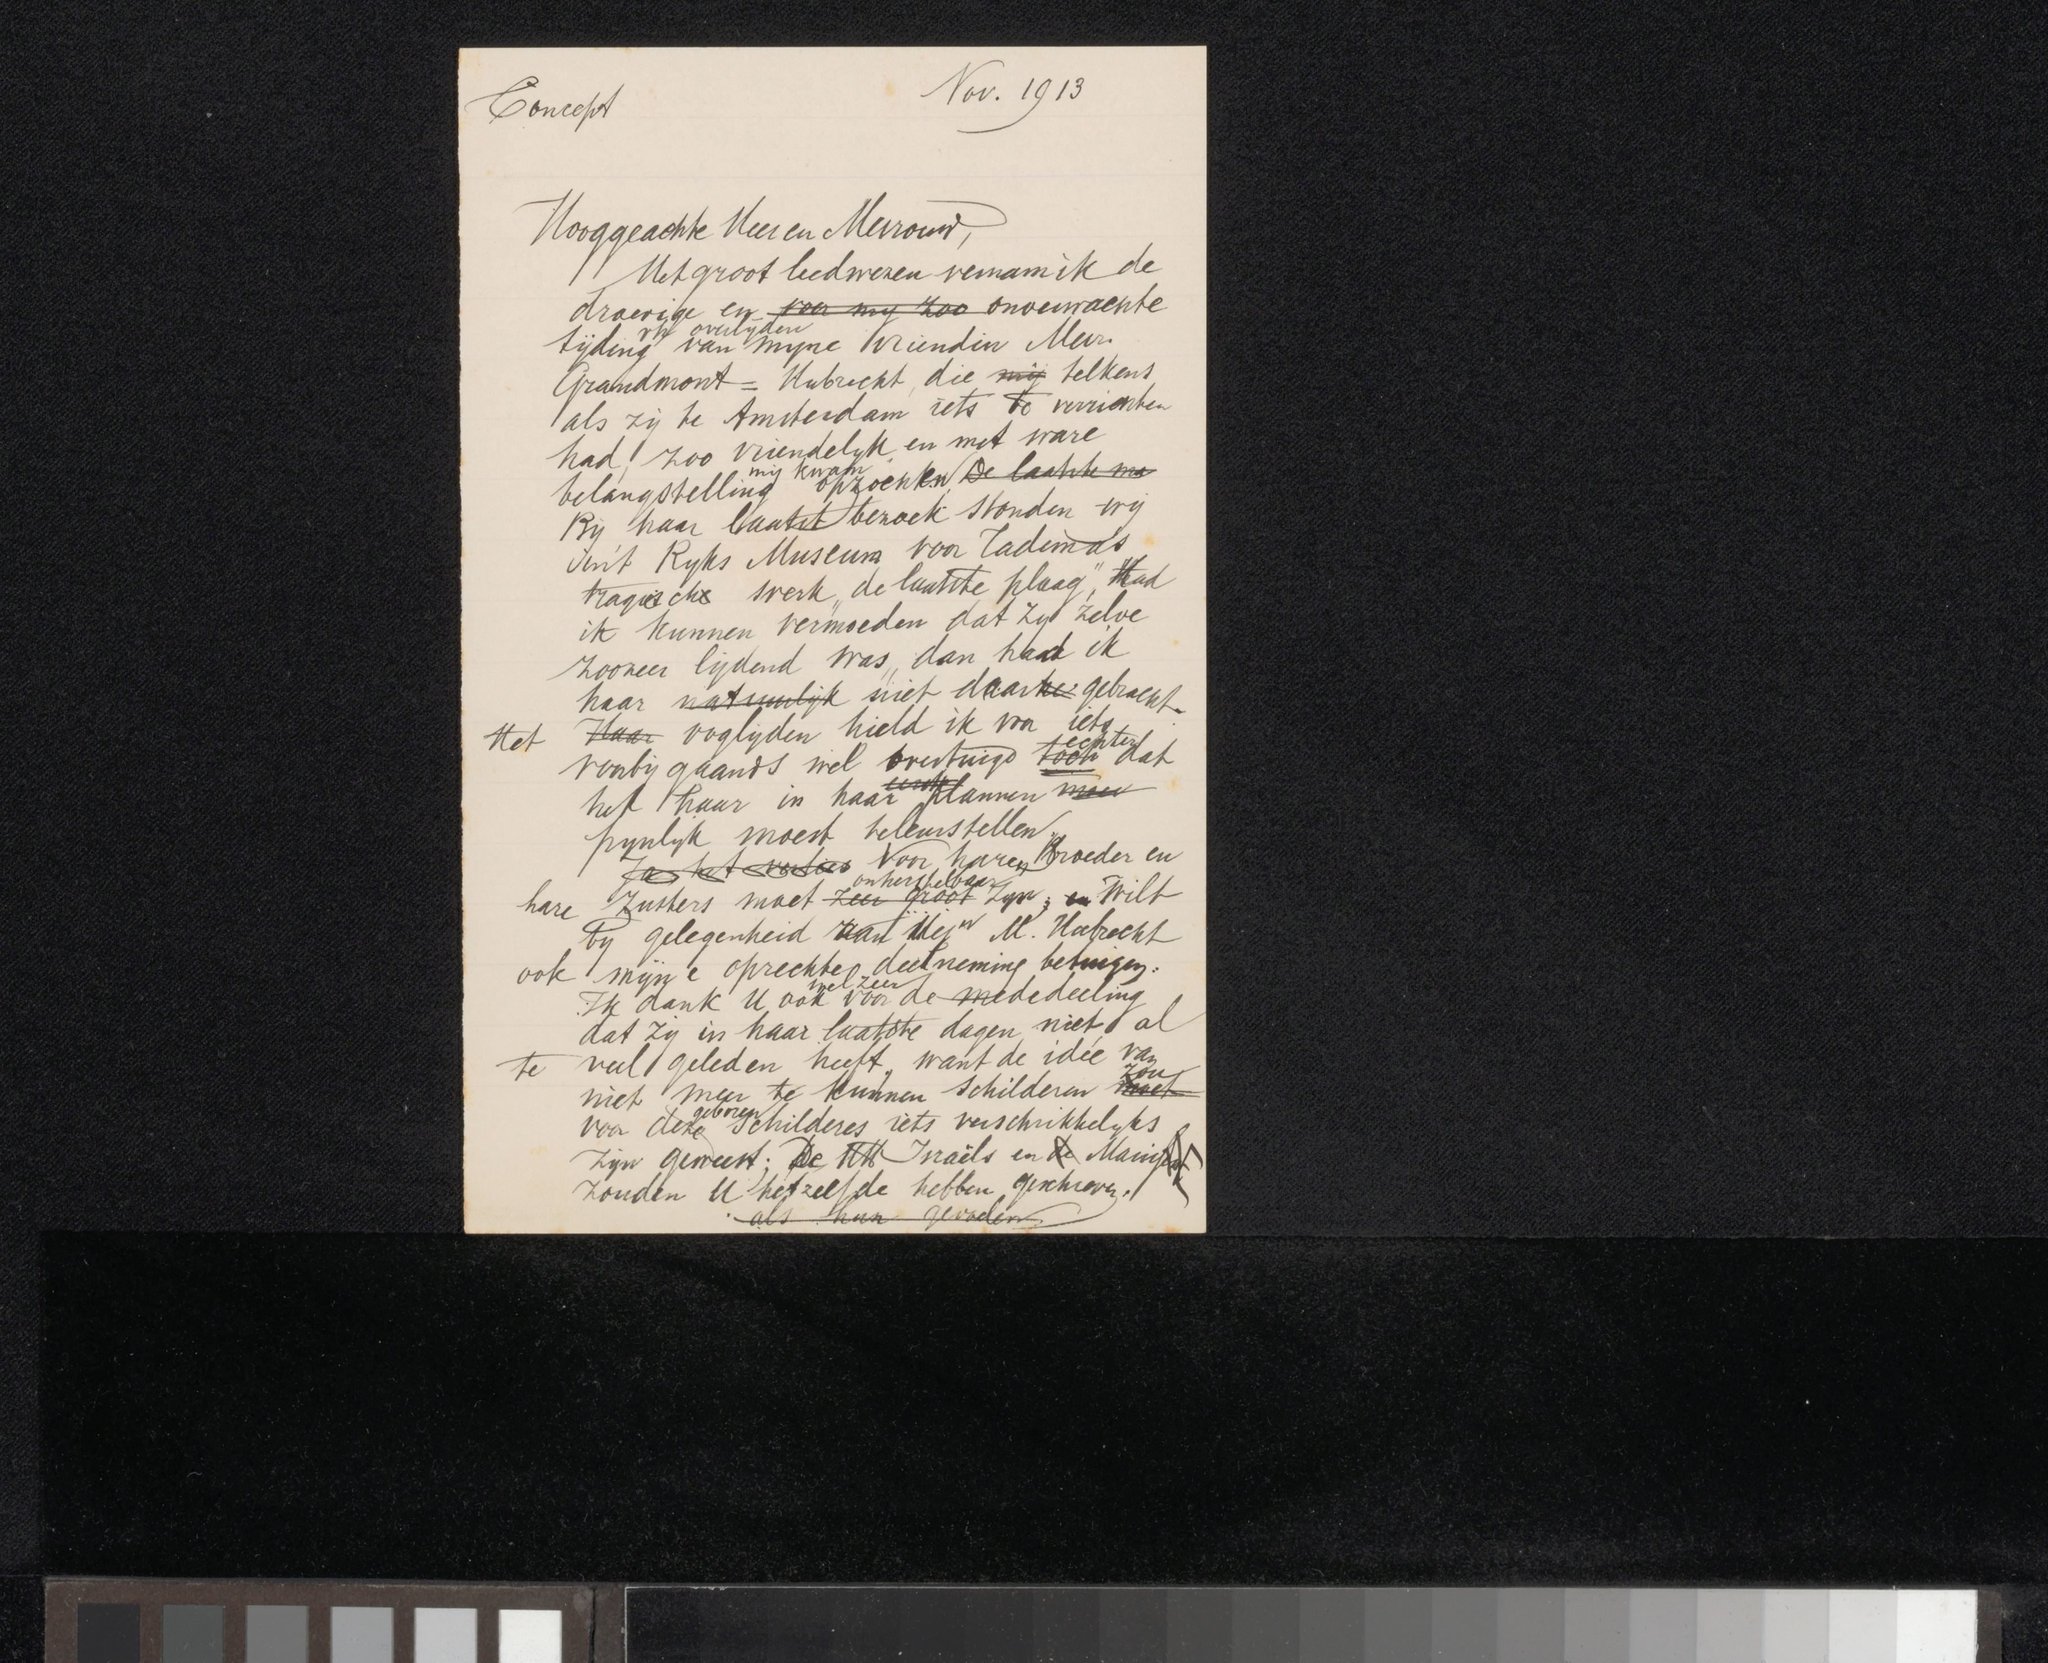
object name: letter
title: Conceptbrief aan anoniem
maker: august allebé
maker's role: draughtsman, print maker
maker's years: 1838-1927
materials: ink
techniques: pen, writing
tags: rotterdam, painter, print maker, draughtsman, bramine hubrecht, rijksmuseum amsterdam, painting (including book-illumination, miniature-painting), diseases, amsterdam